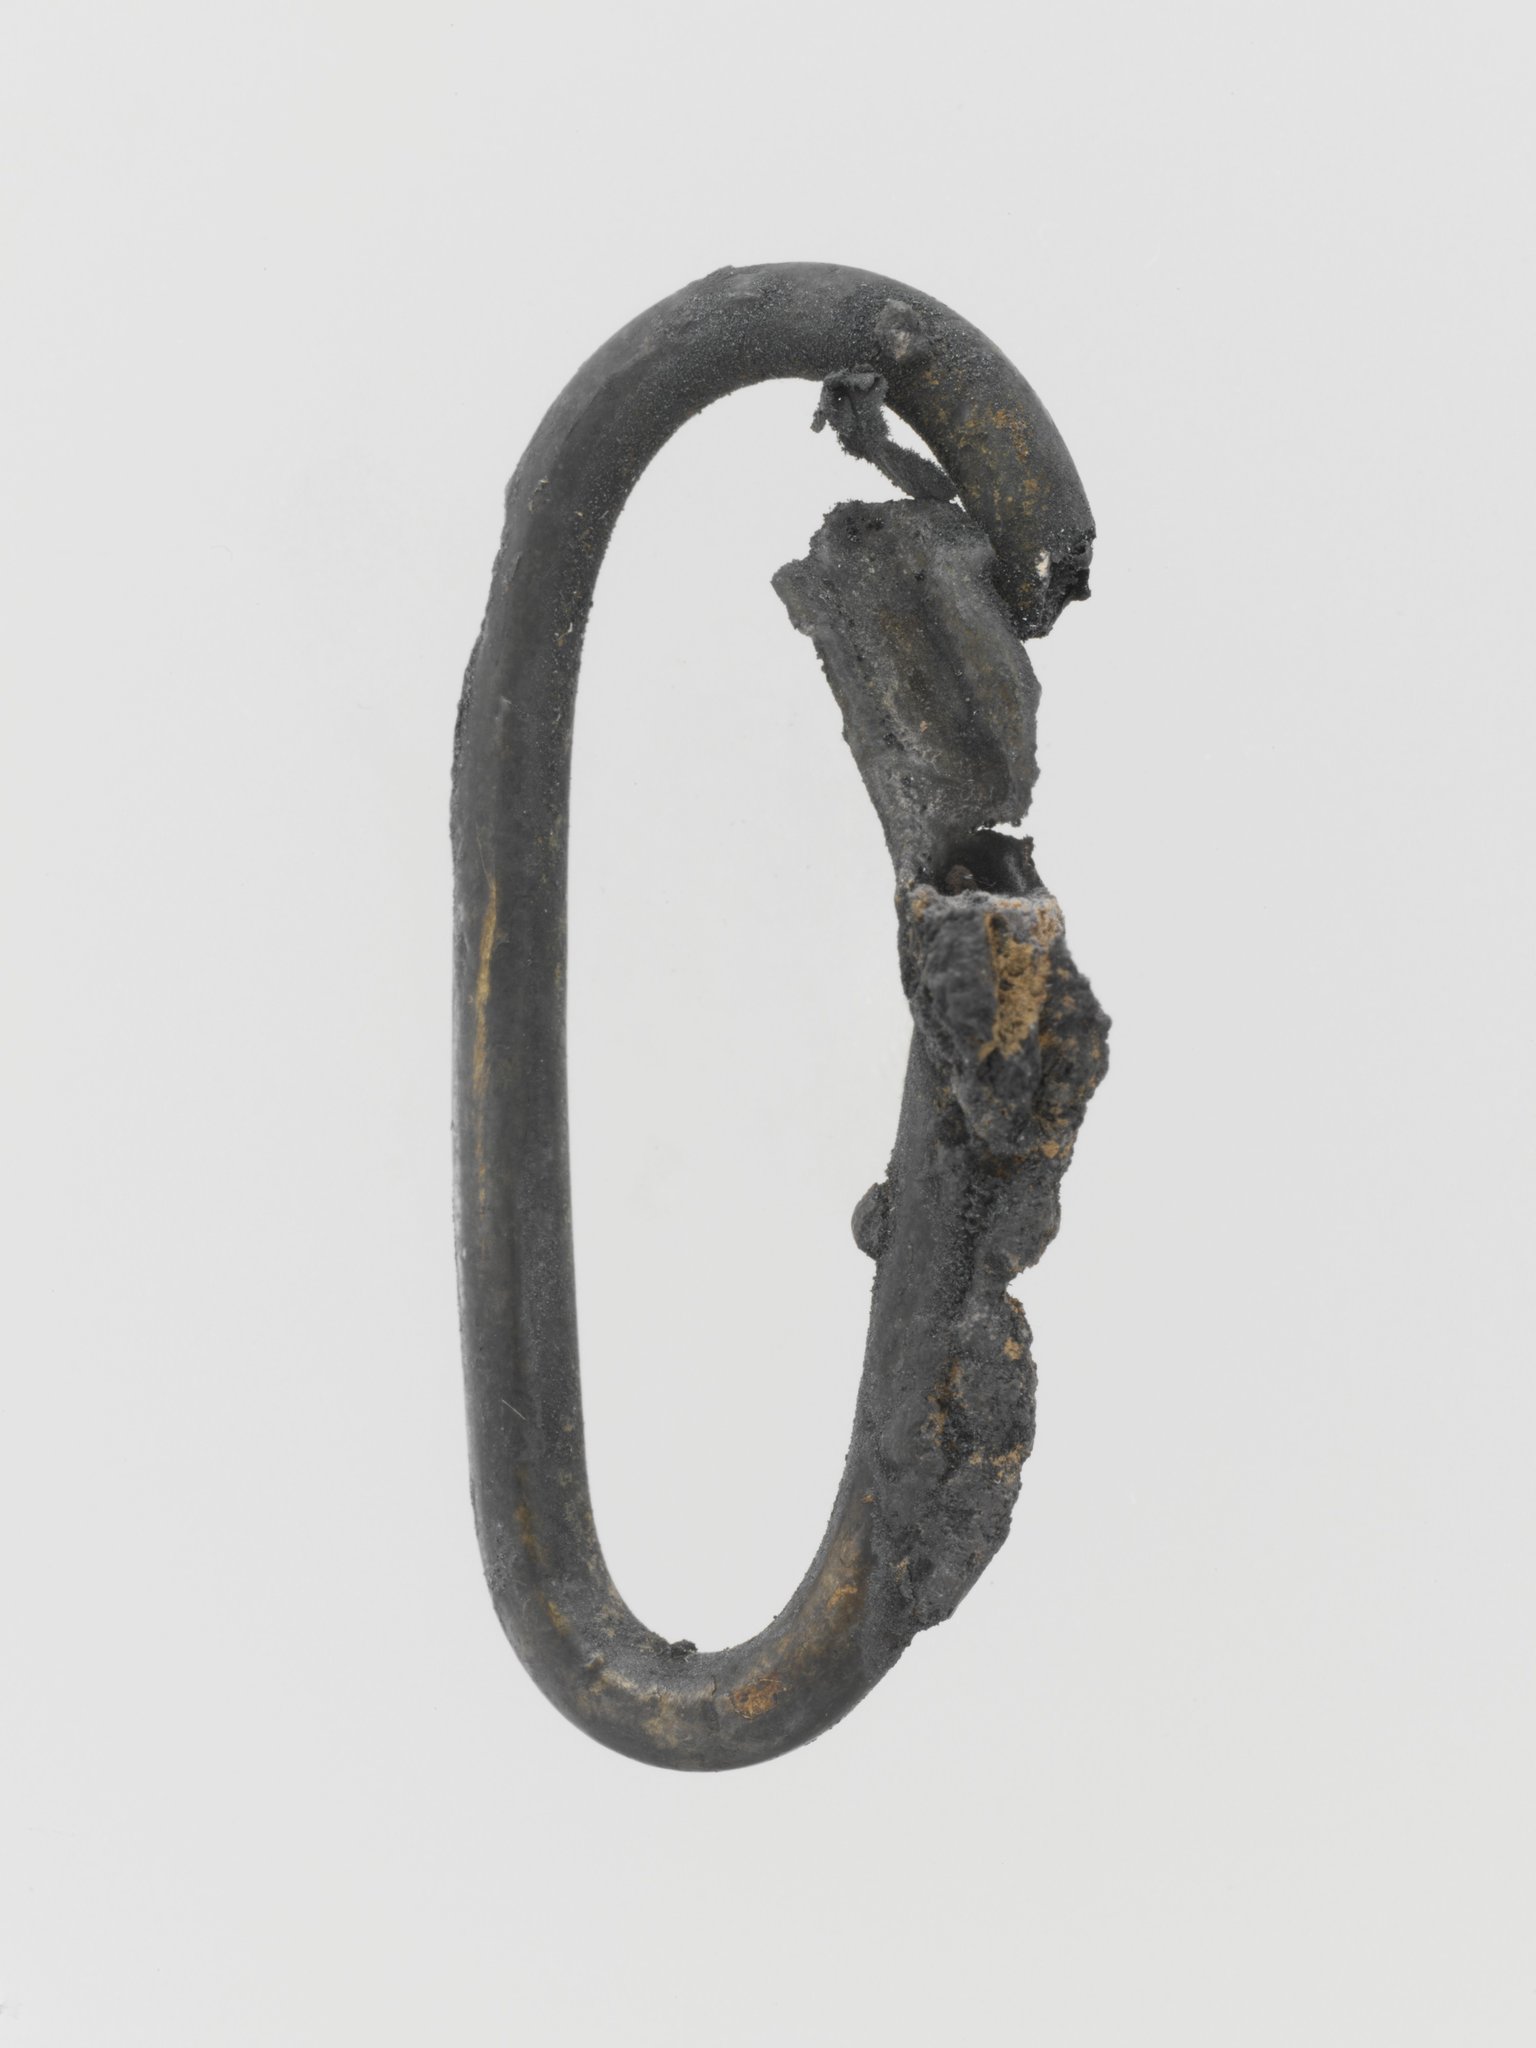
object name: earring or spiral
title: Silver spiral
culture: cypriot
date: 1600-1050 BCE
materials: silver